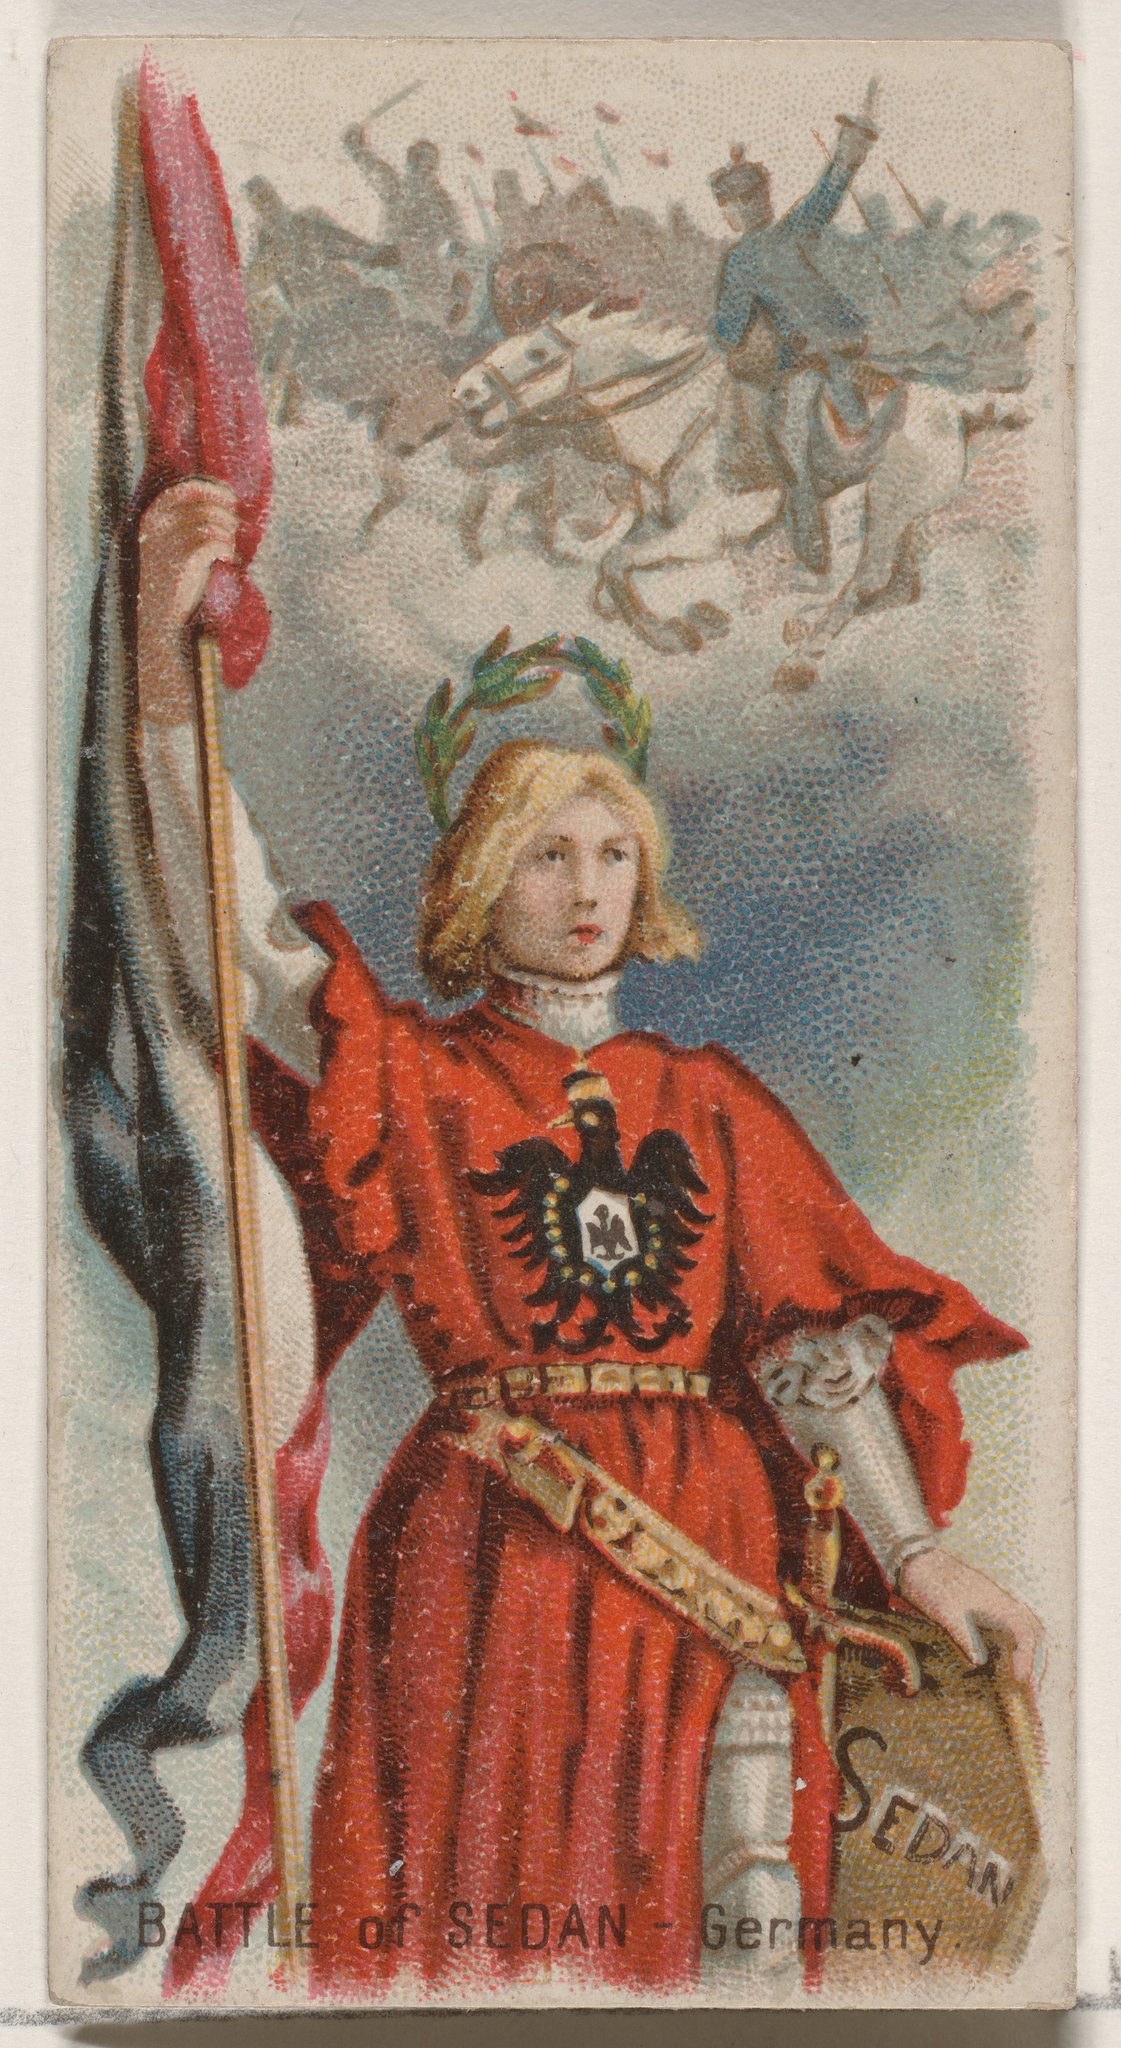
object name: print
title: Battle of Sedan, Germany, from the Holidays series (N80) for Duke brand cigarettes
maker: w. duke, sons & co.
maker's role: publisher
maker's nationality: american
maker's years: 1870-1920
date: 1890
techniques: color lithograph